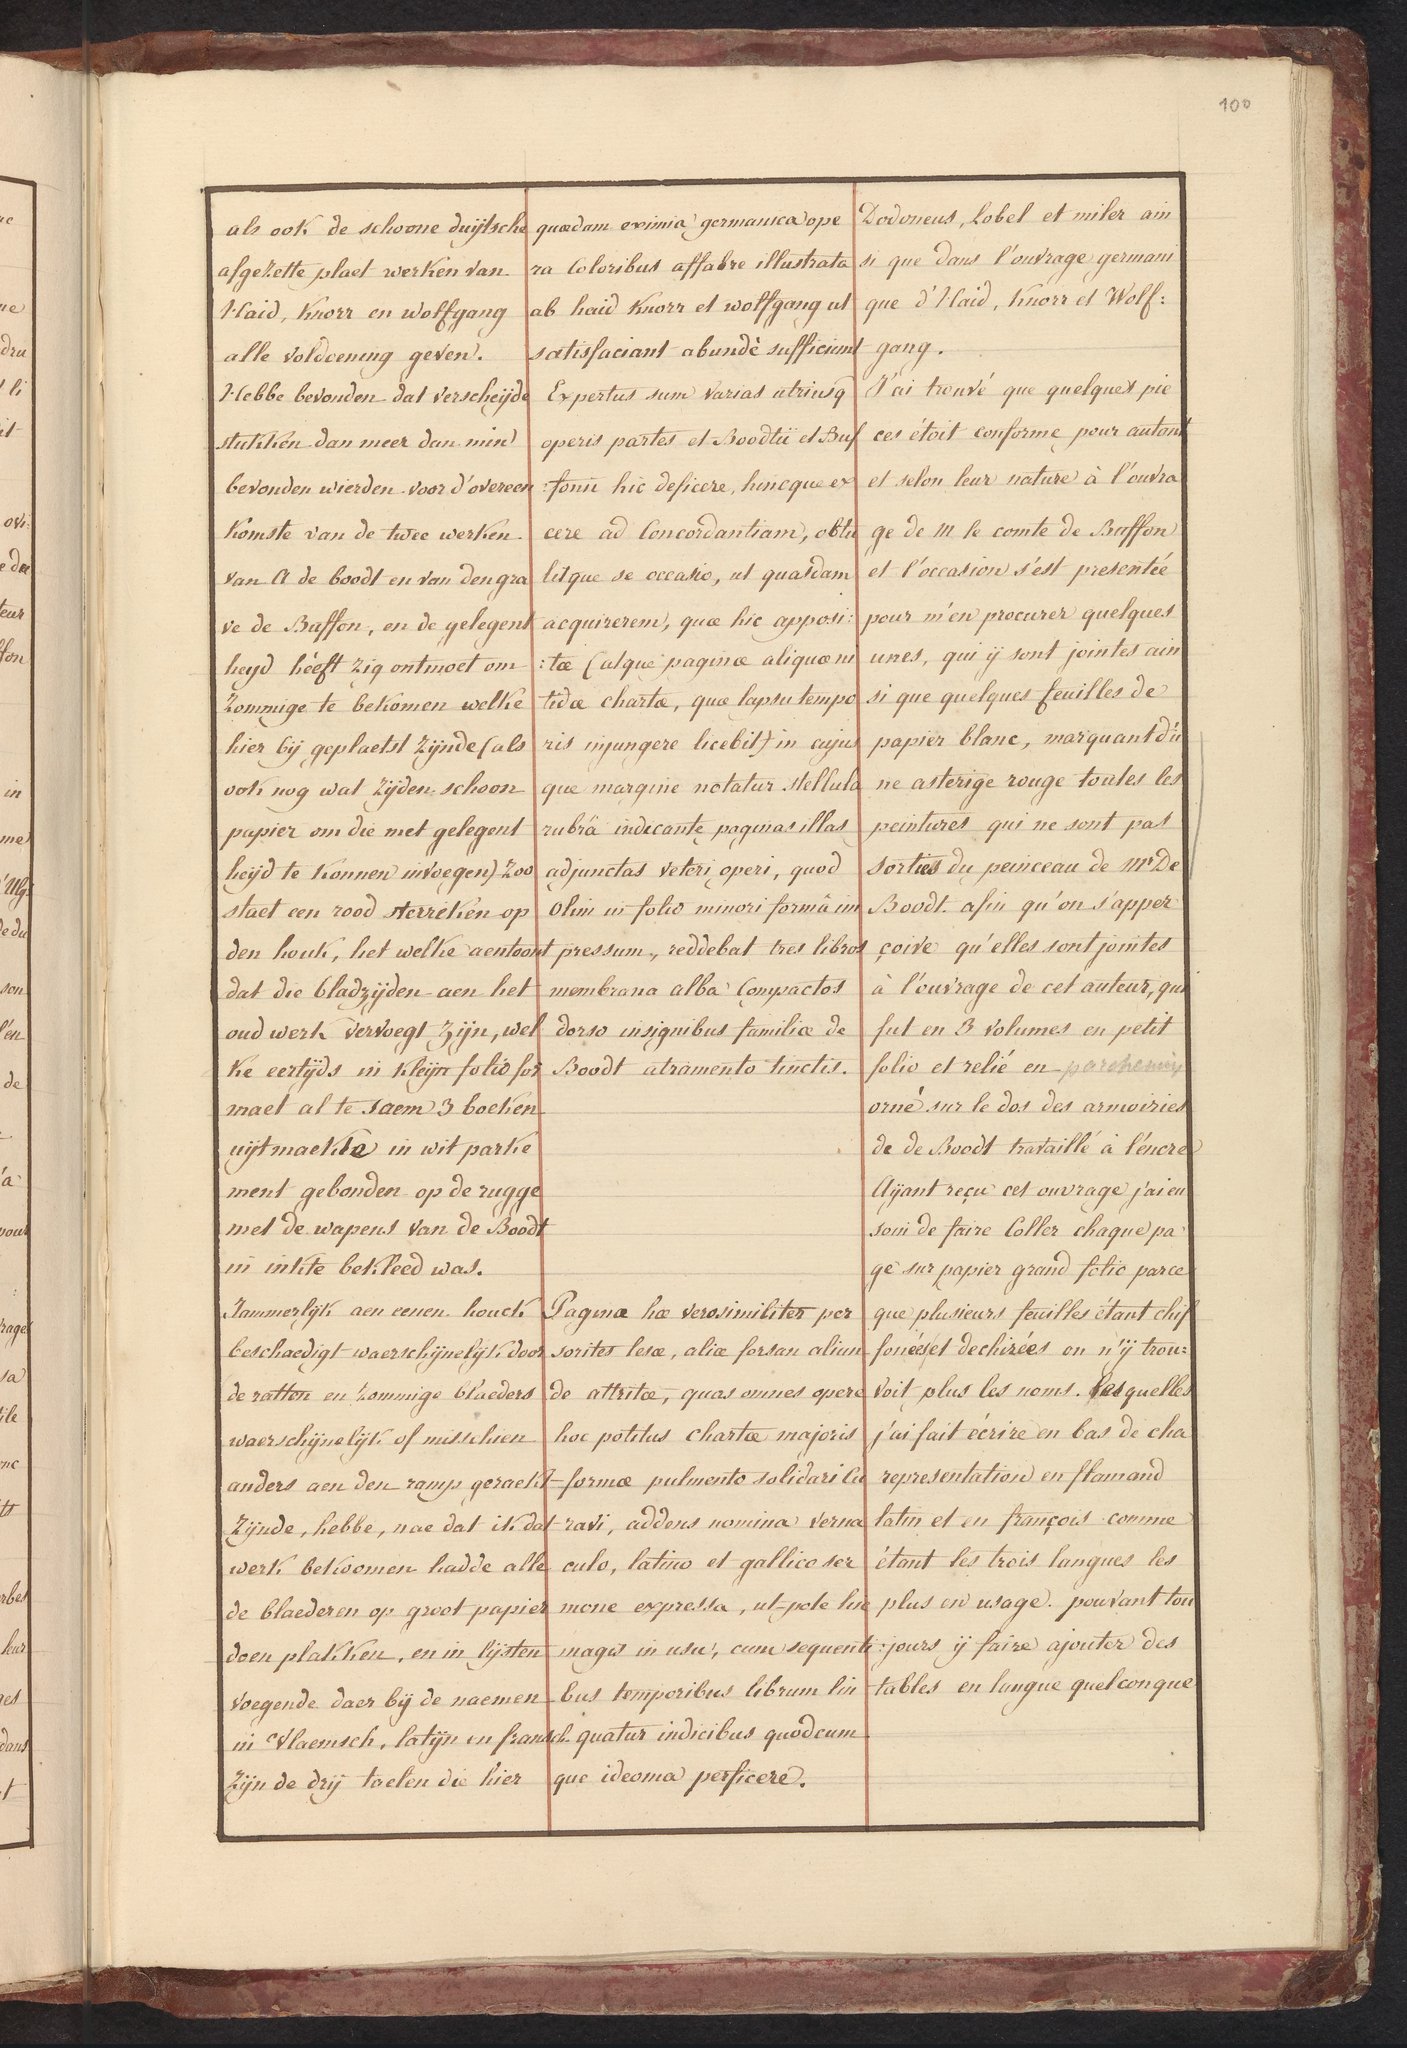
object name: manuscript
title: Vervolg van het bericht aan de liefhebber van de natuurlijke historie (derde bladzijde)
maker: joseph van huerne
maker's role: kunstliefhebber, mecenas, verzamelaar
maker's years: 1752-1844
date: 1596-1610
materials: ink, paper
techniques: pen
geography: bruges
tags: handwriting, written text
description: Vervolg (derde bladzijde) van de inleidende teksten in drie kolommen in het Nederlands, Latijn en Frans, waarin de samensteller van de albums zich tot de lezer richt. Voor het begin zie p. 23. Onderdeel van het eerste album met tekeningen van viervoeters. Eerste van twaalf albums met tekeningen van dieren, vogels en planten bekend rond 1600, gemaakt in opdracht van keizer Rudolf II. Met toelichting in Nederlands, Latijn en Frans.